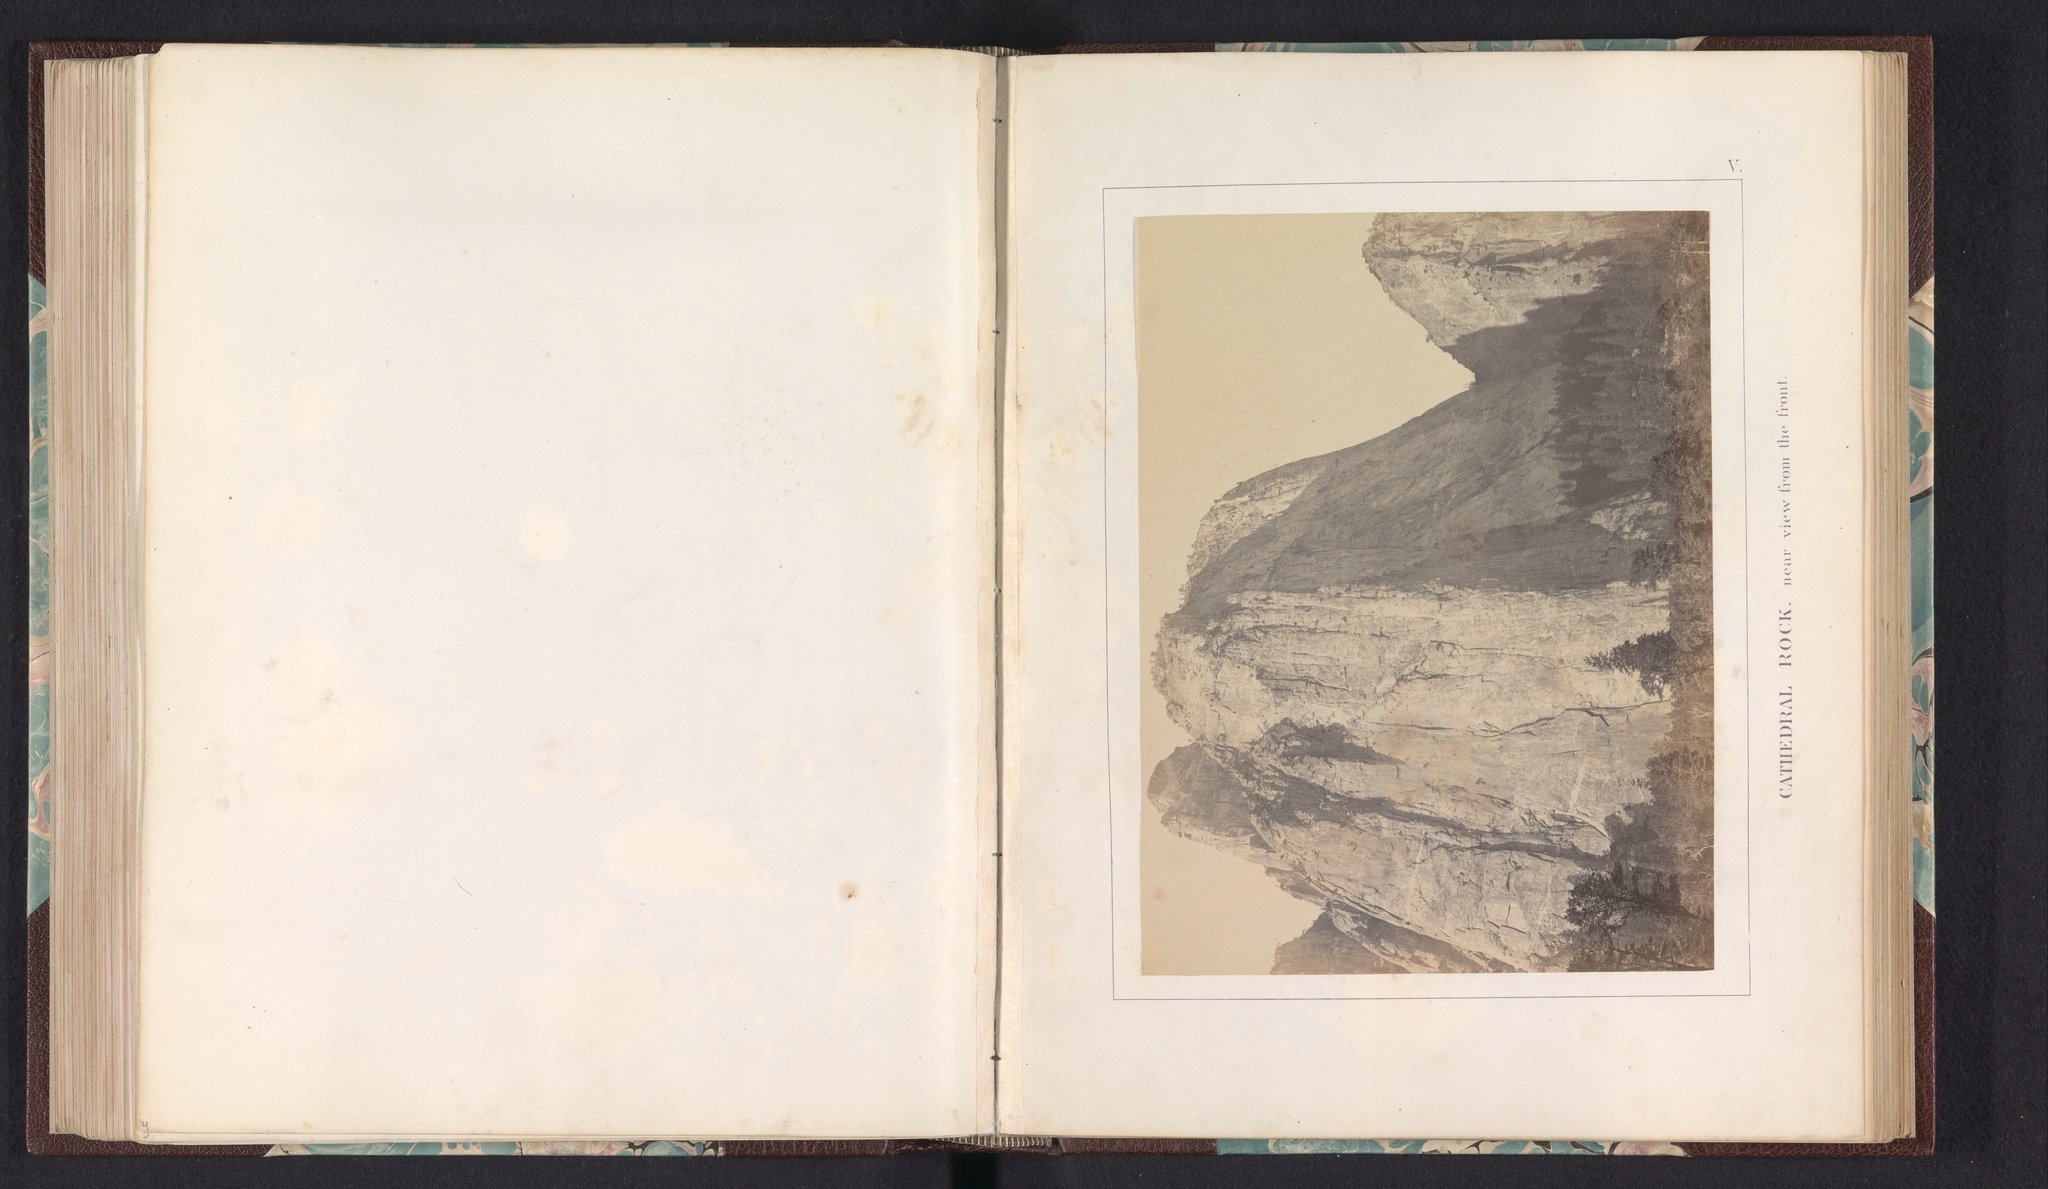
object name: photograph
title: Cathedral Rock, near view from the front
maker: carleton e. watkins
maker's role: fotograaf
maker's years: 1829-1916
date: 1860-1868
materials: photographic support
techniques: albumen print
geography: yosemite valley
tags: dale, valley, rock-formations, mountains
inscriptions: number: ‘V.’